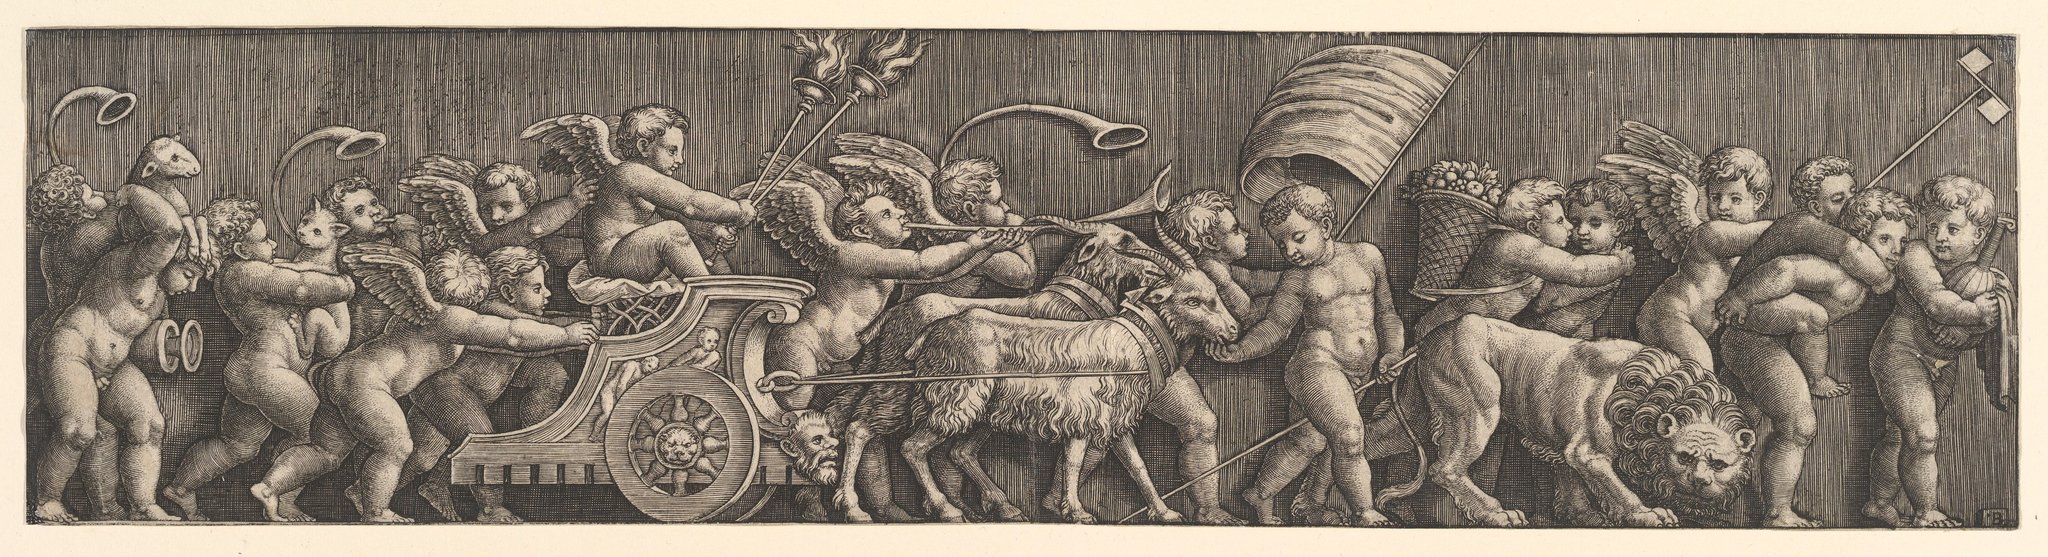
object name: print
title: A frieze arrangement depcting the Triumph of Love; Cupid in a Chariot led by goats, many other putti filling the composition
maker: master of the die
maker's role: artist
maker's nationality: italian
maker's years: 1525-1560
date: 1530-1560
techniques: engraving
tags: trumpets,cupid,goats,lions,chariots